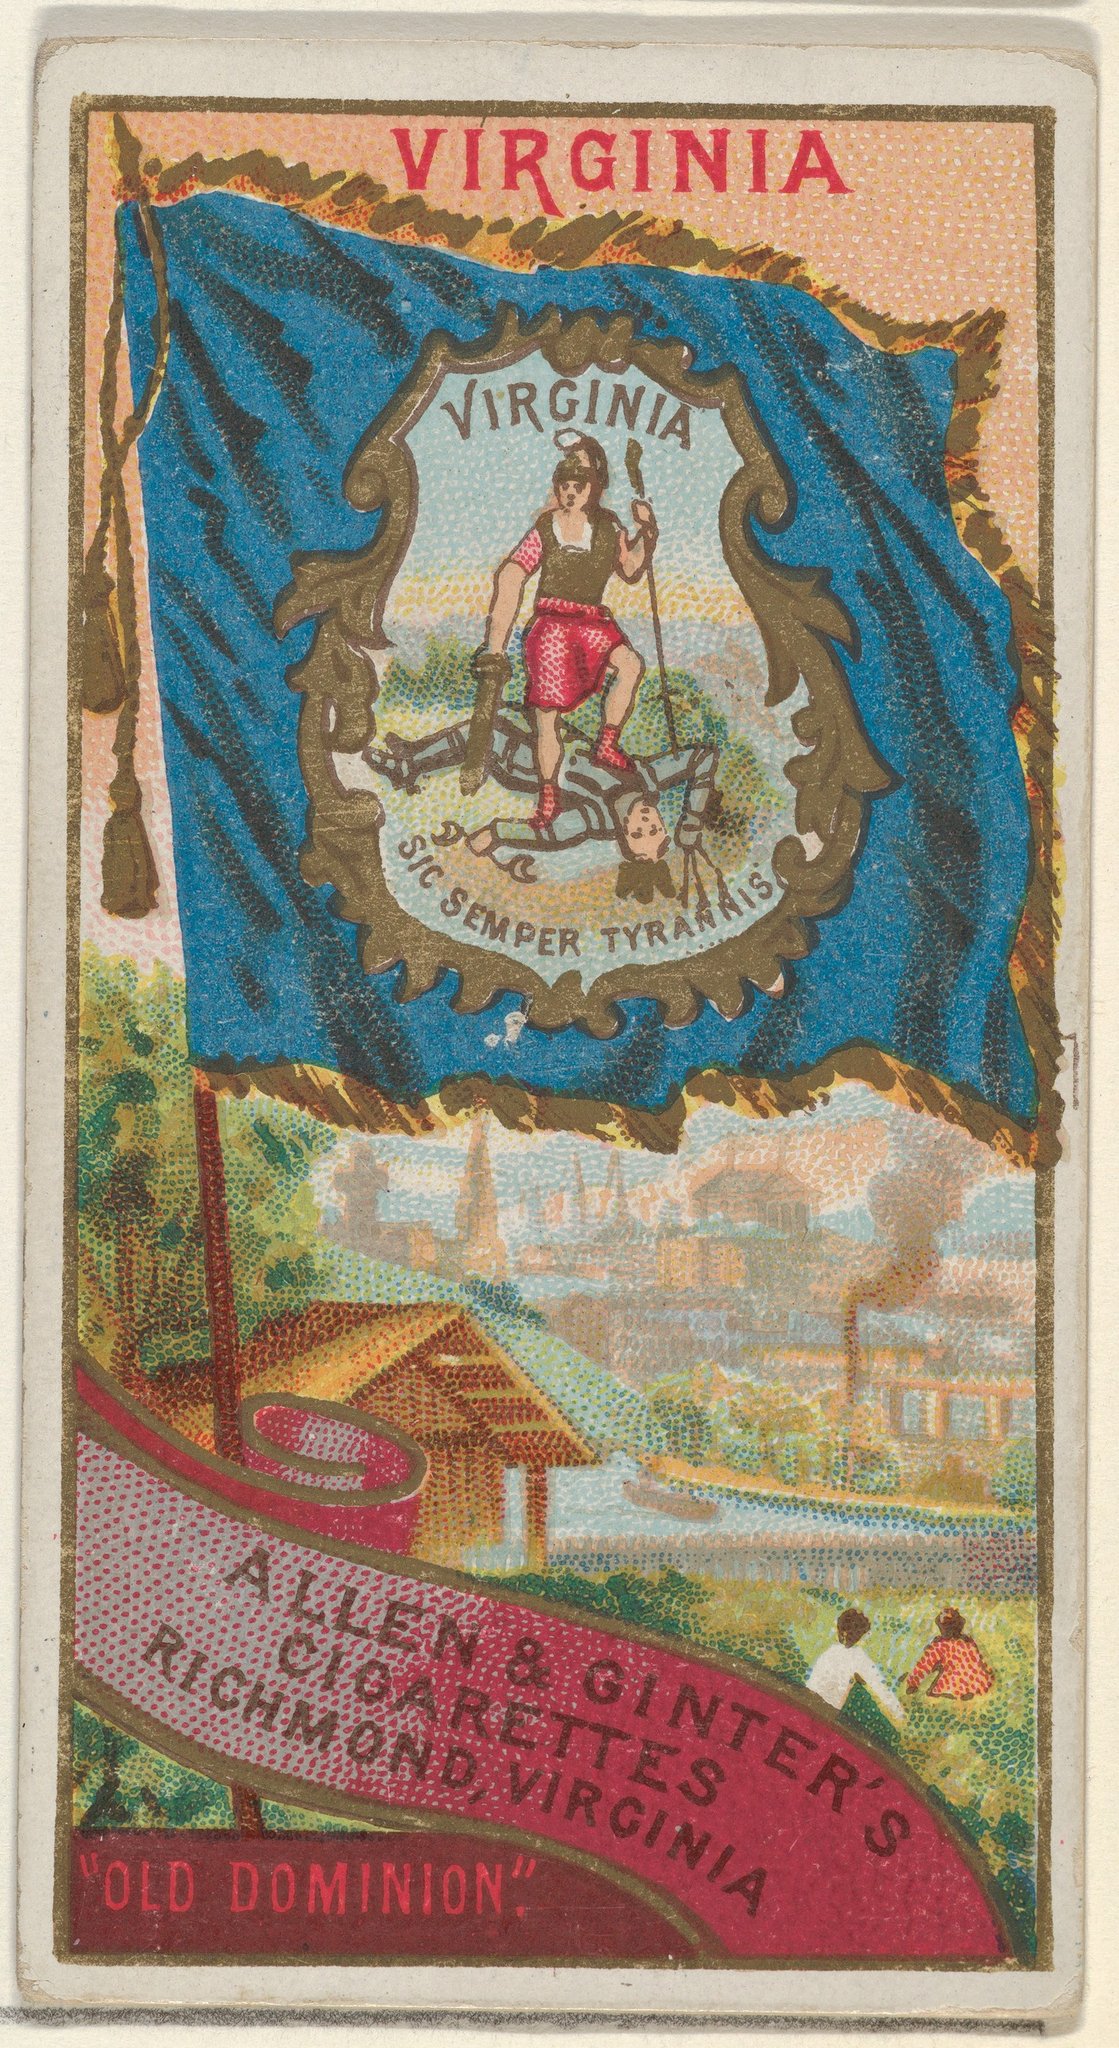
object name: print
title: Virginia, from Flags of the States and Territories (N11) for Allen & Ginter Cigarettes Brands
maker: allen & ginter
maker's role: publisher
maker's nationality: american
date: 1888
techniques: color lithograph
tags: flags